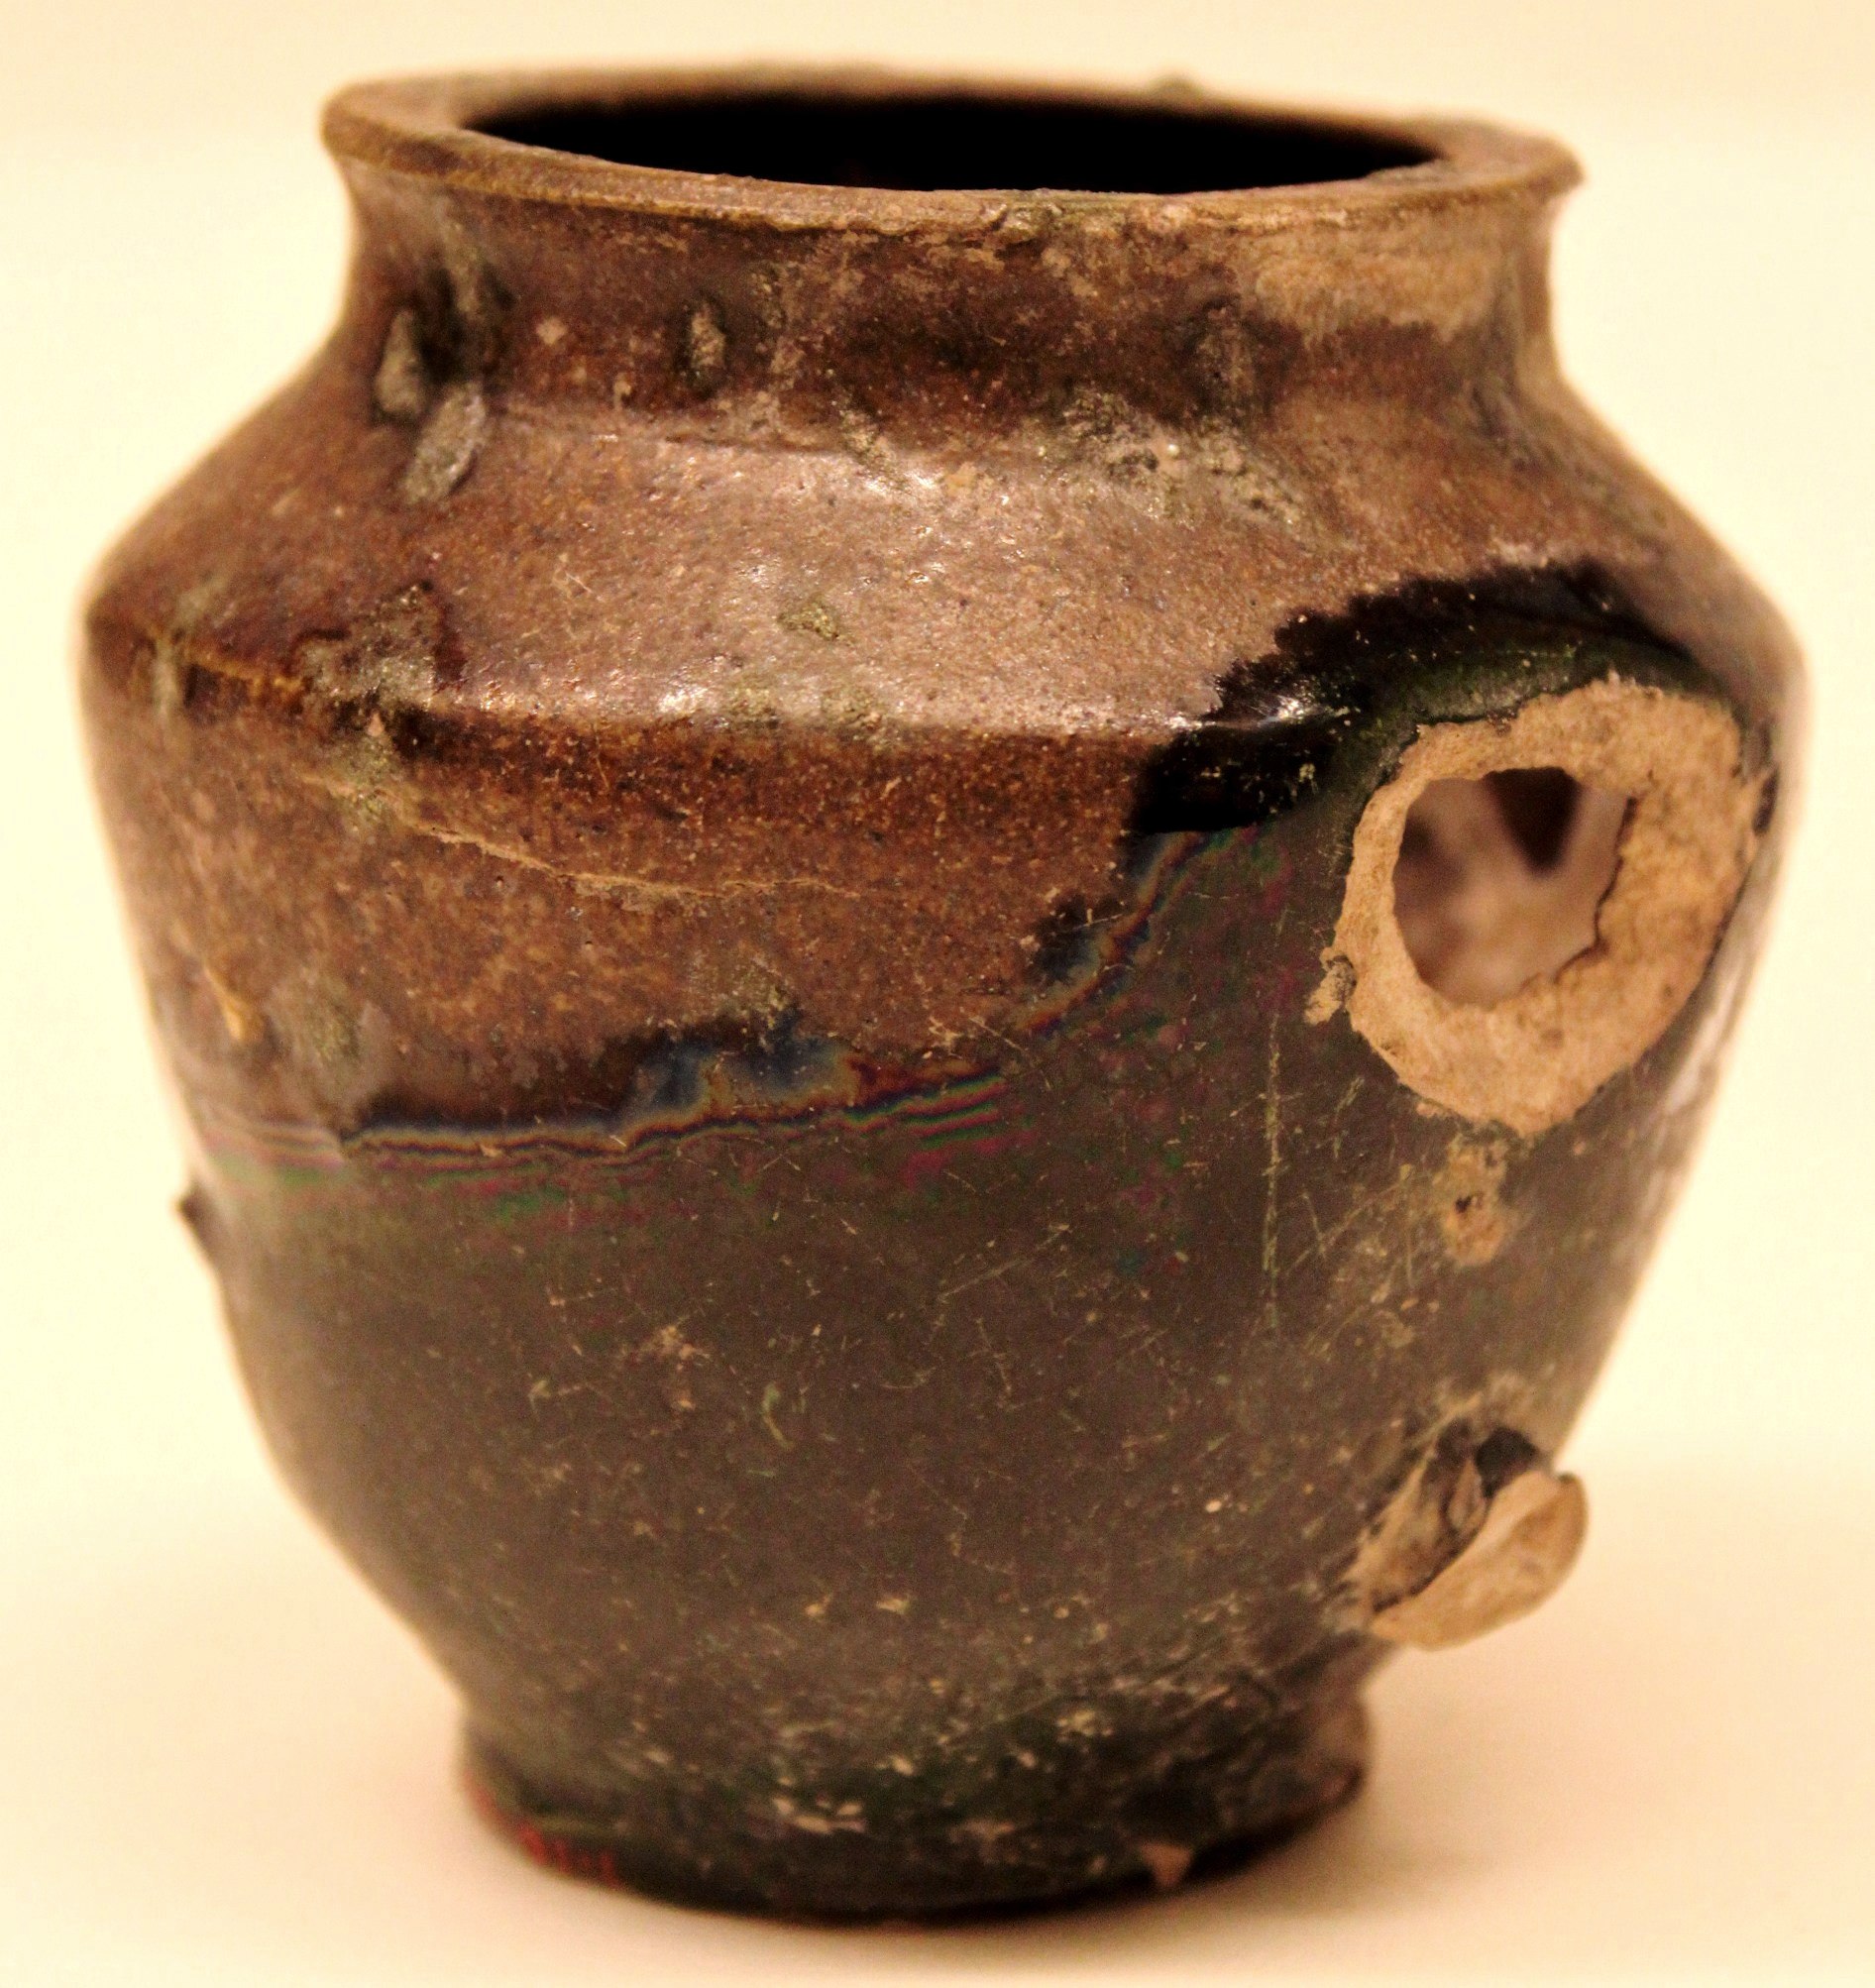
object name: jar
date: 801-1000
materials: earthenware, glaze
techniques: painting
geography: iran